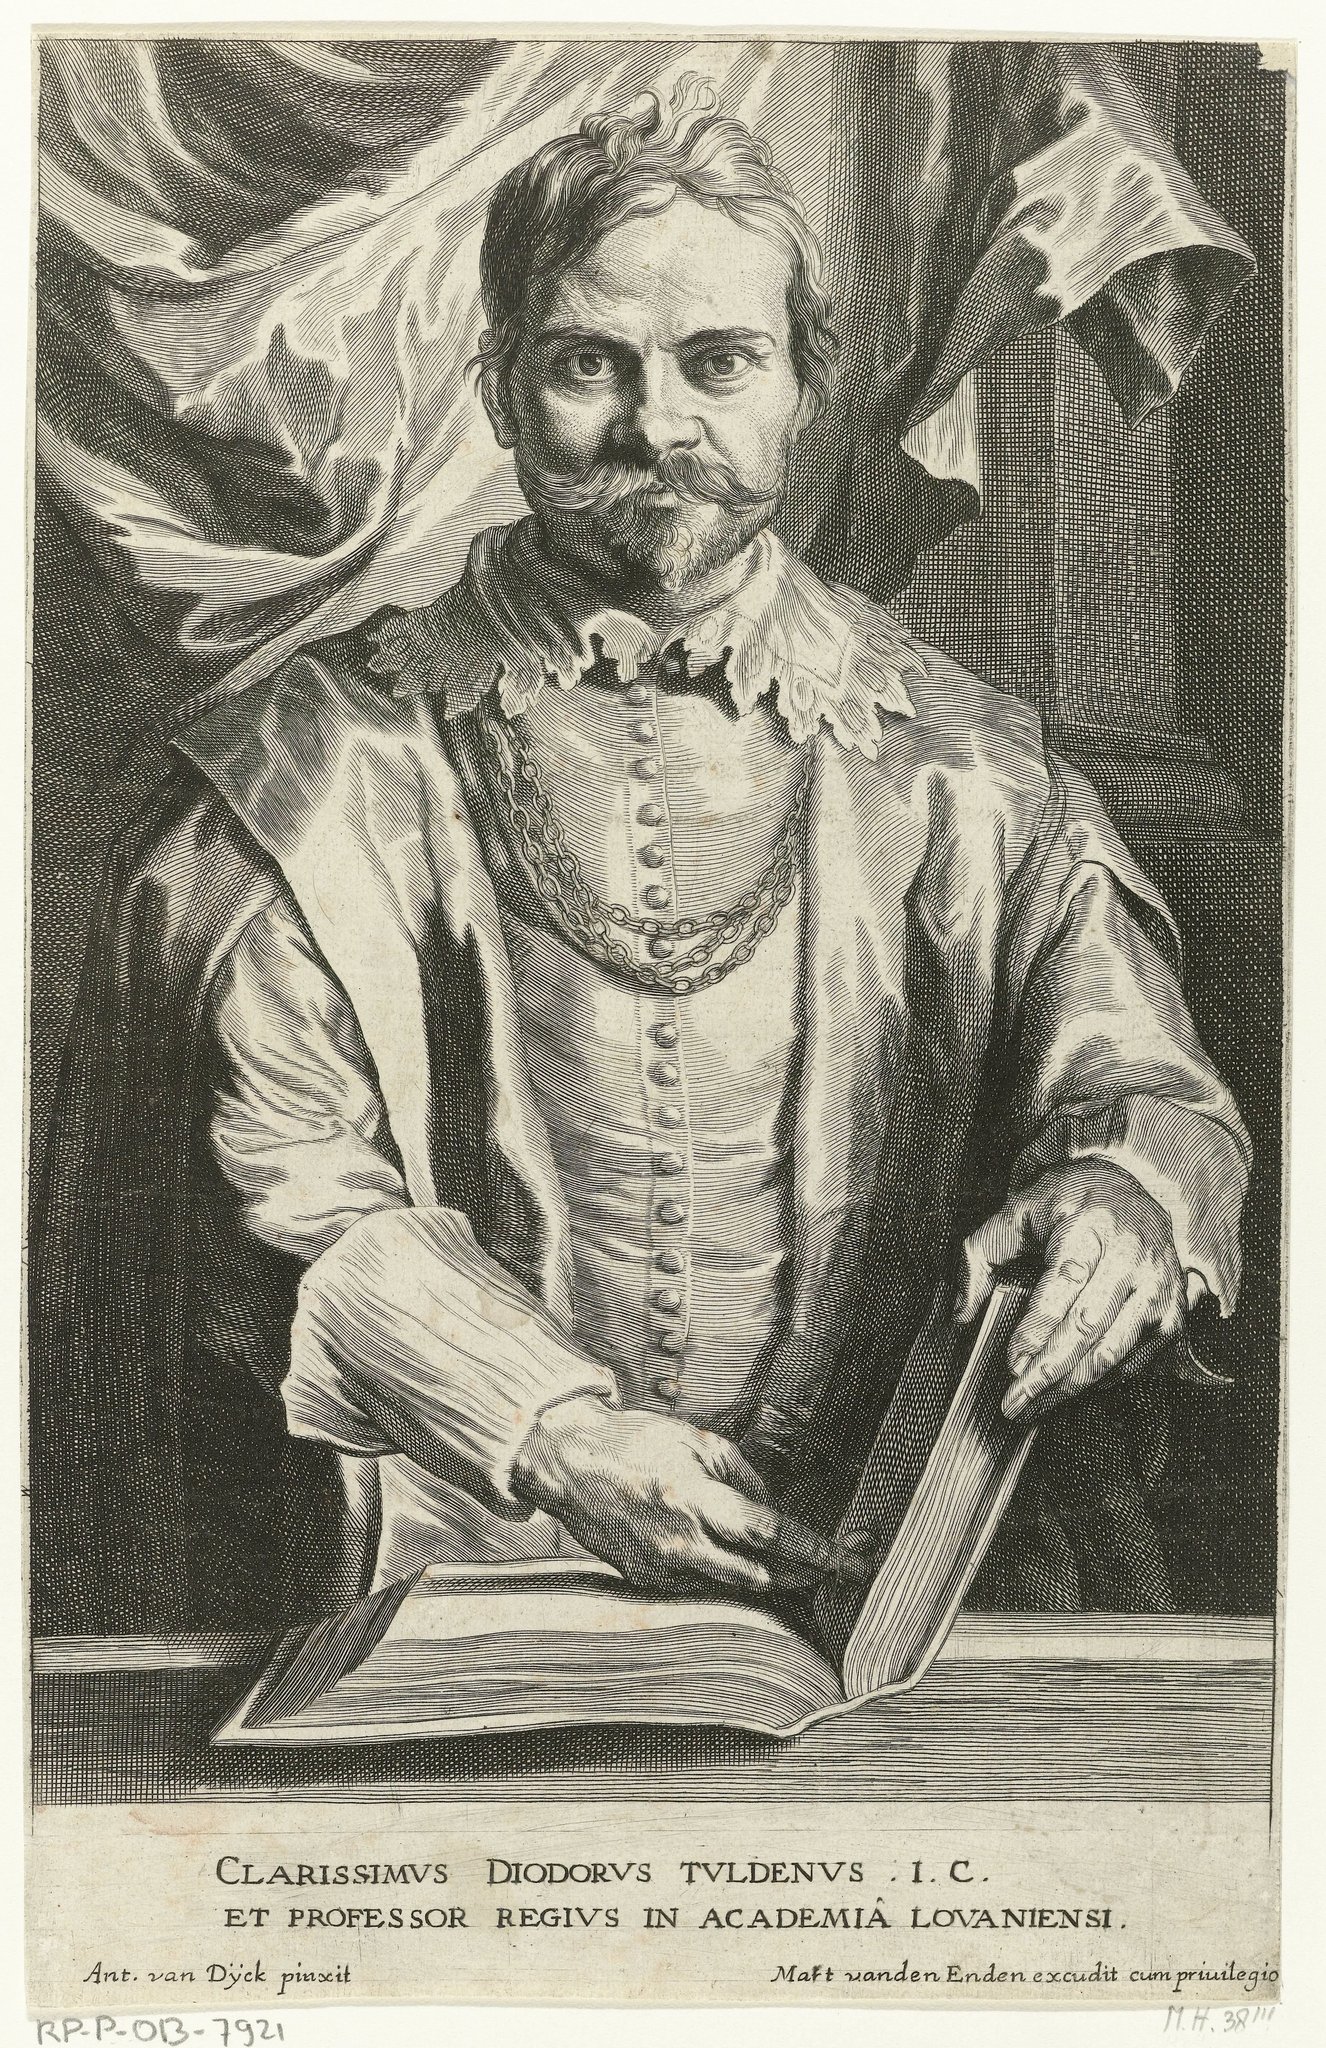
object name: print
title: Portret van Theodore van Tulden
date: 1628-1670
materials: paper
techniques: engraving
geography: antwerp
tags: book - mm - book open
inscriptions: collector's mark: Lugt 240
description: Portret van Theodore van Tulden, ten halven lijve. Hij staat voor een tafel met daarop een opengeslagen boek. Met zijn rechterhand wijst hij op een bladzijde. In de marge een tweeregelig onderschrift in het Latijn.